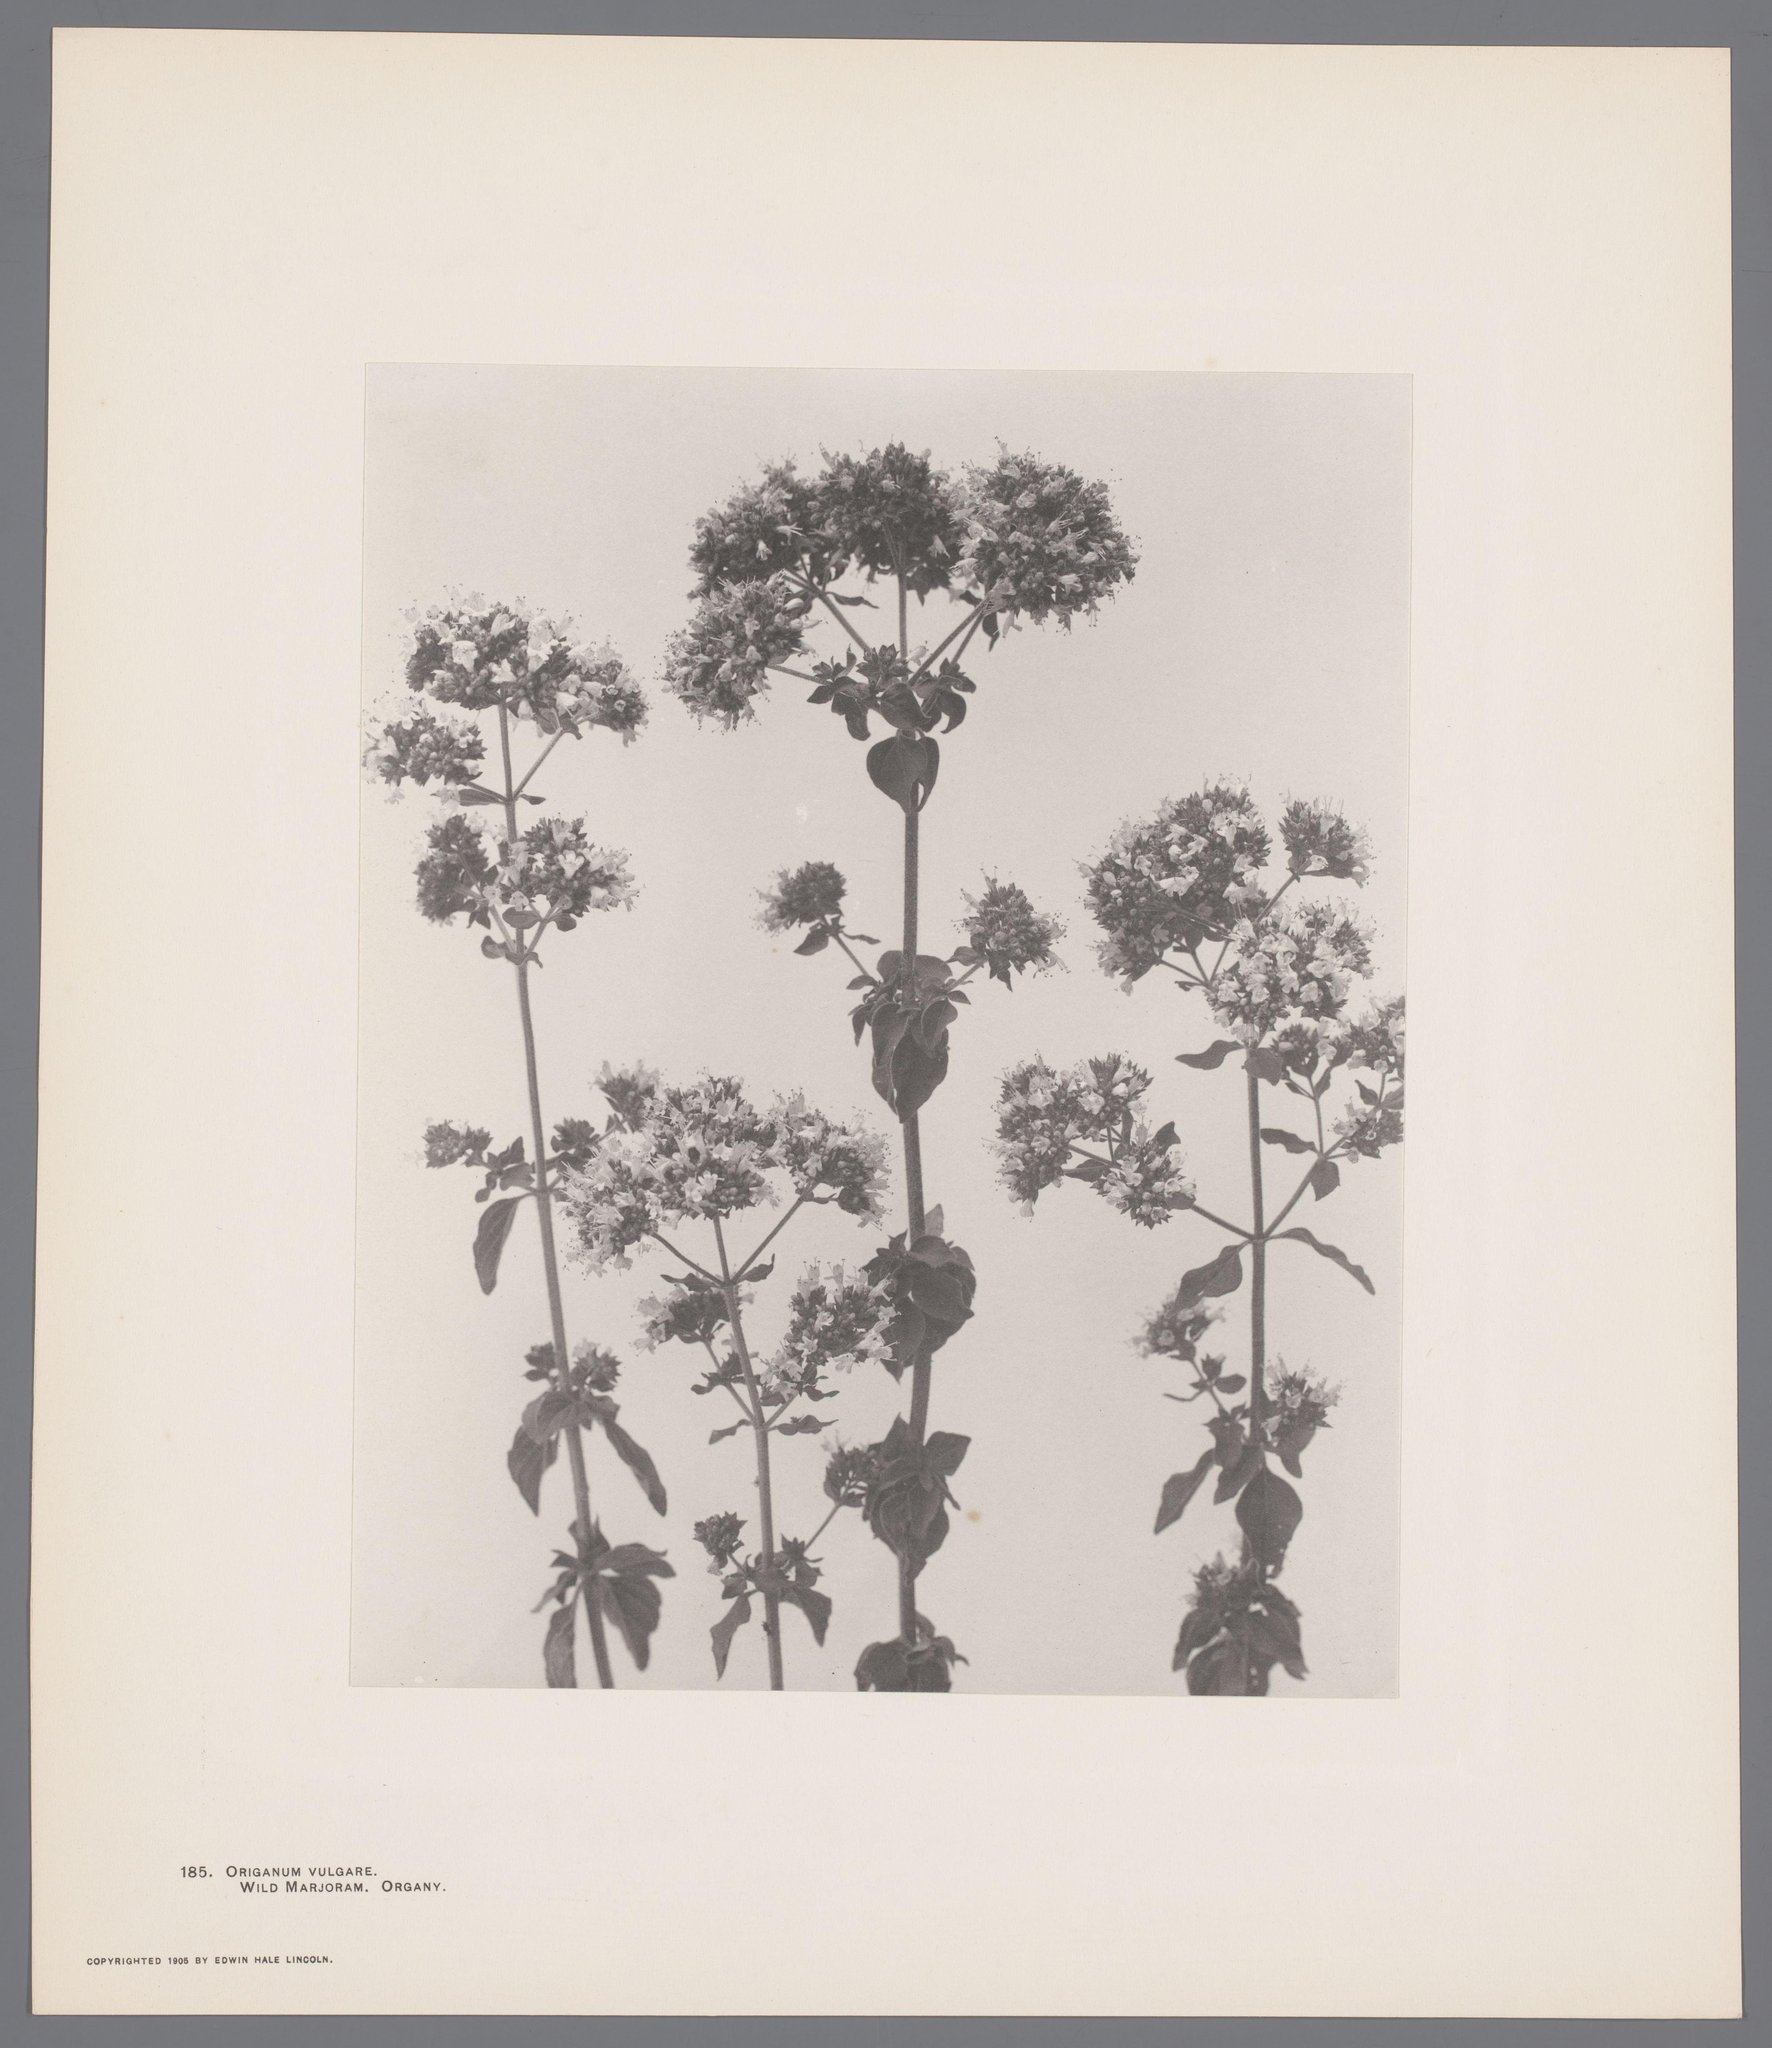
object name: photograph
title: Lantaarnplaatje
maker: edwin hale lincoln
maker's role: fotograaf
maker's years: 1848-1938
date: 1905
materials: paper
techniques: photography